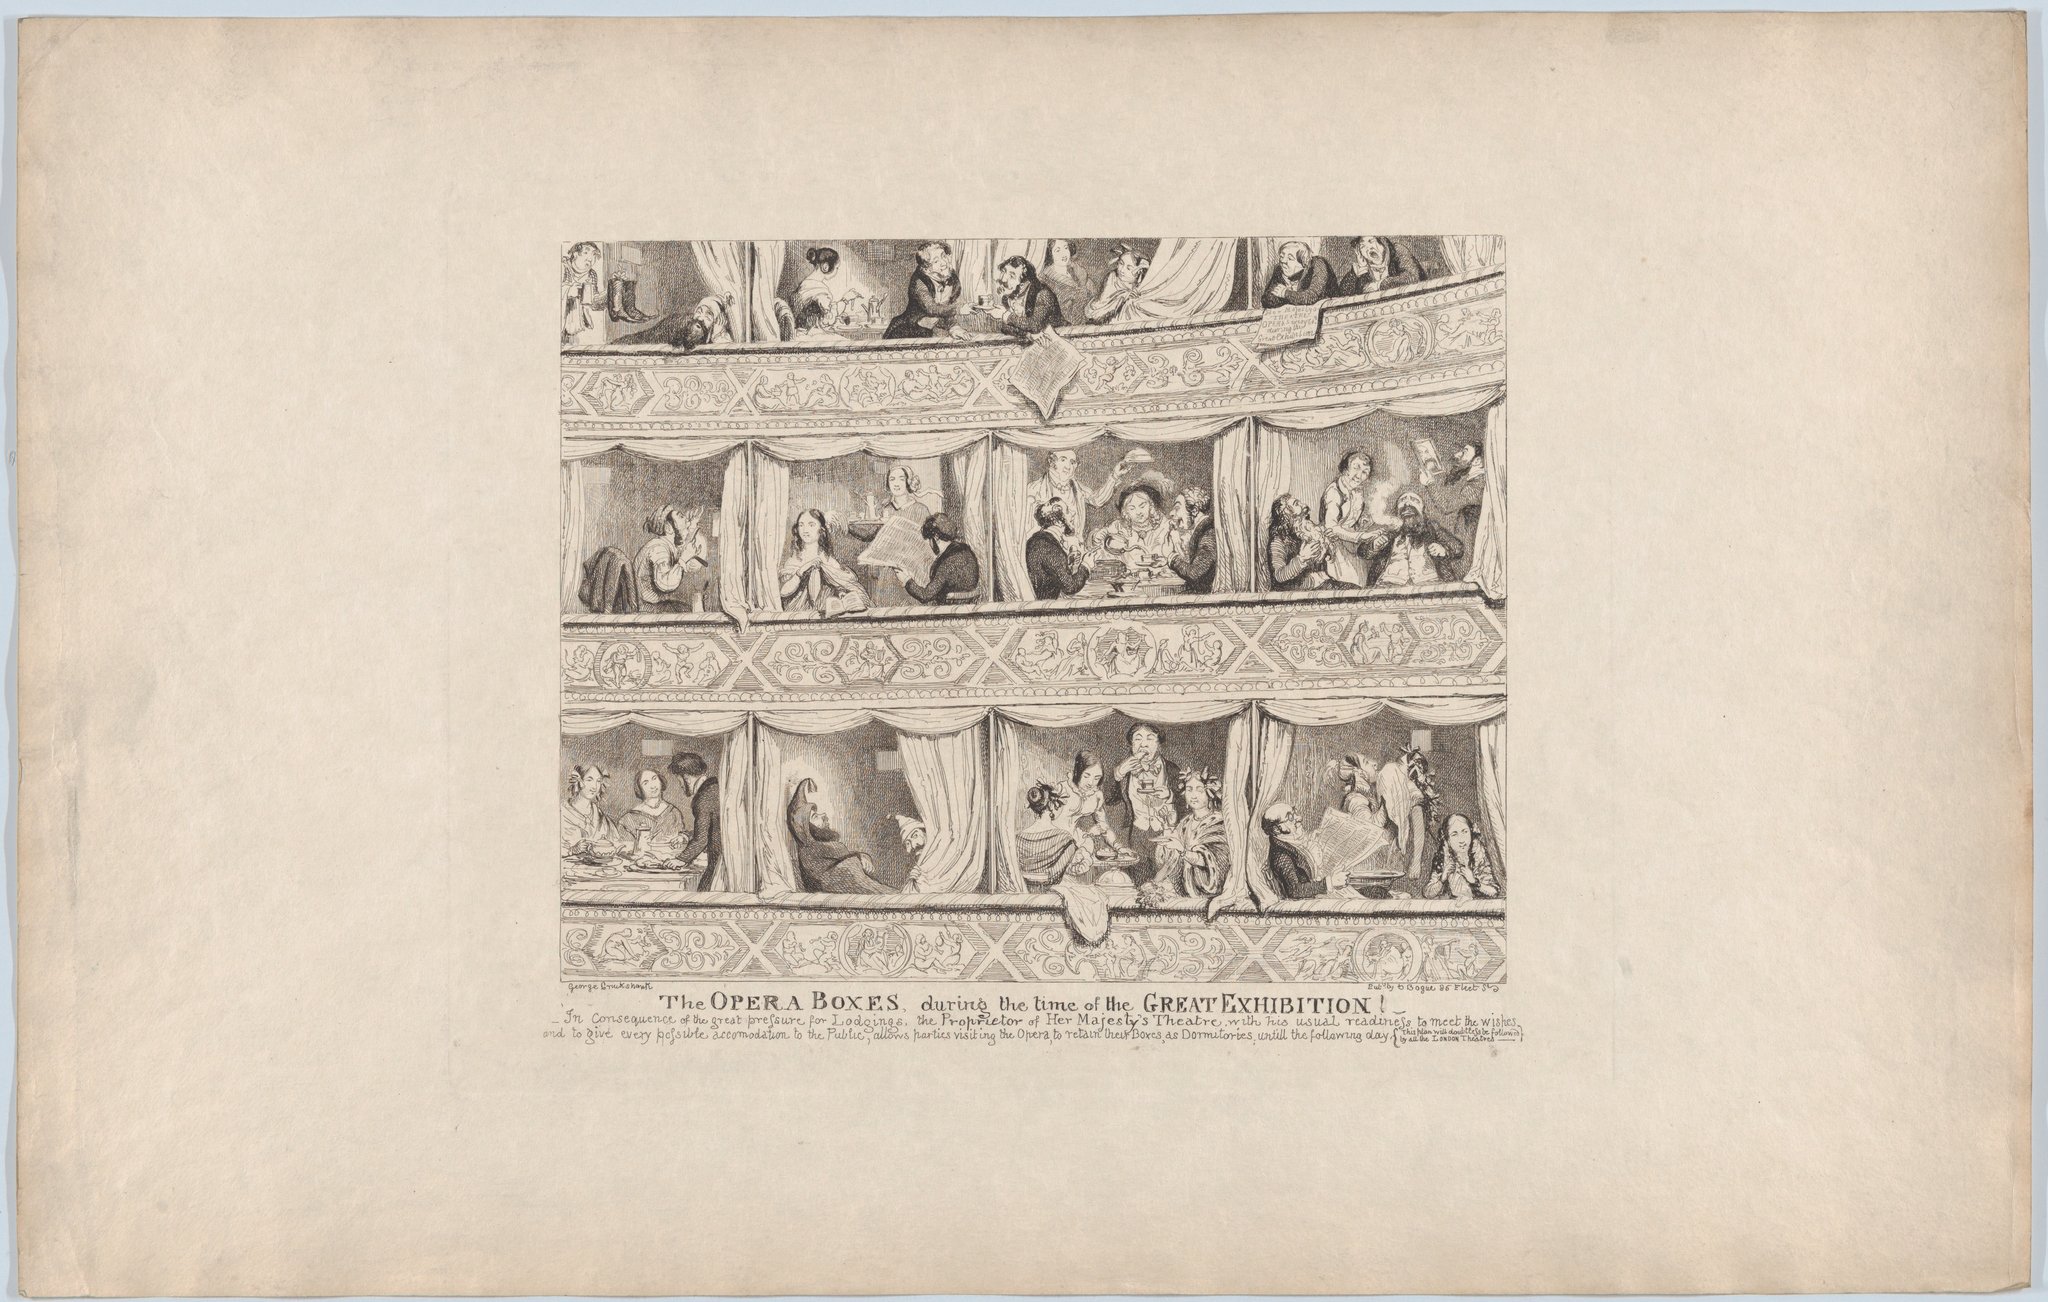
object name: print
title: The Opera Boxes During the Time of the Great Exhibition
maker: george cruikshank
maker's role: artist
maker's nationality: british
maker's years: 1792-1878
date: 1851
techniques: etching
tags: theatre,men,women